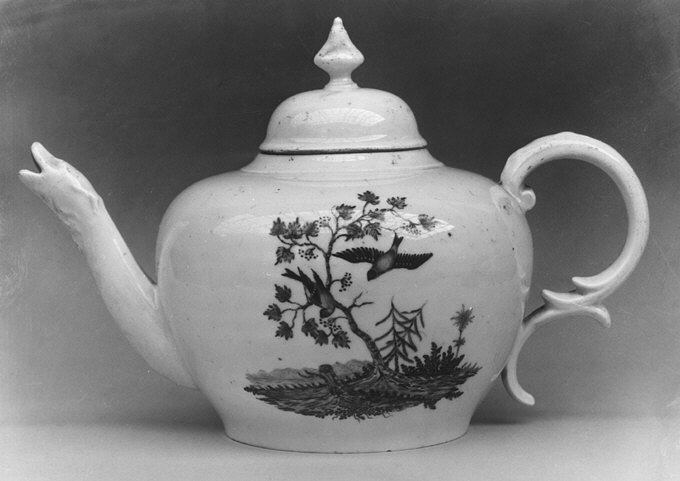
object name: teapot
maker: nymphenburg porcelain manufactory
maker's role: manufactory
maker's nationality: german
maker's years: 1747-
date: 1763-1767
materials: hard paste porcelain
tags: birds,trees